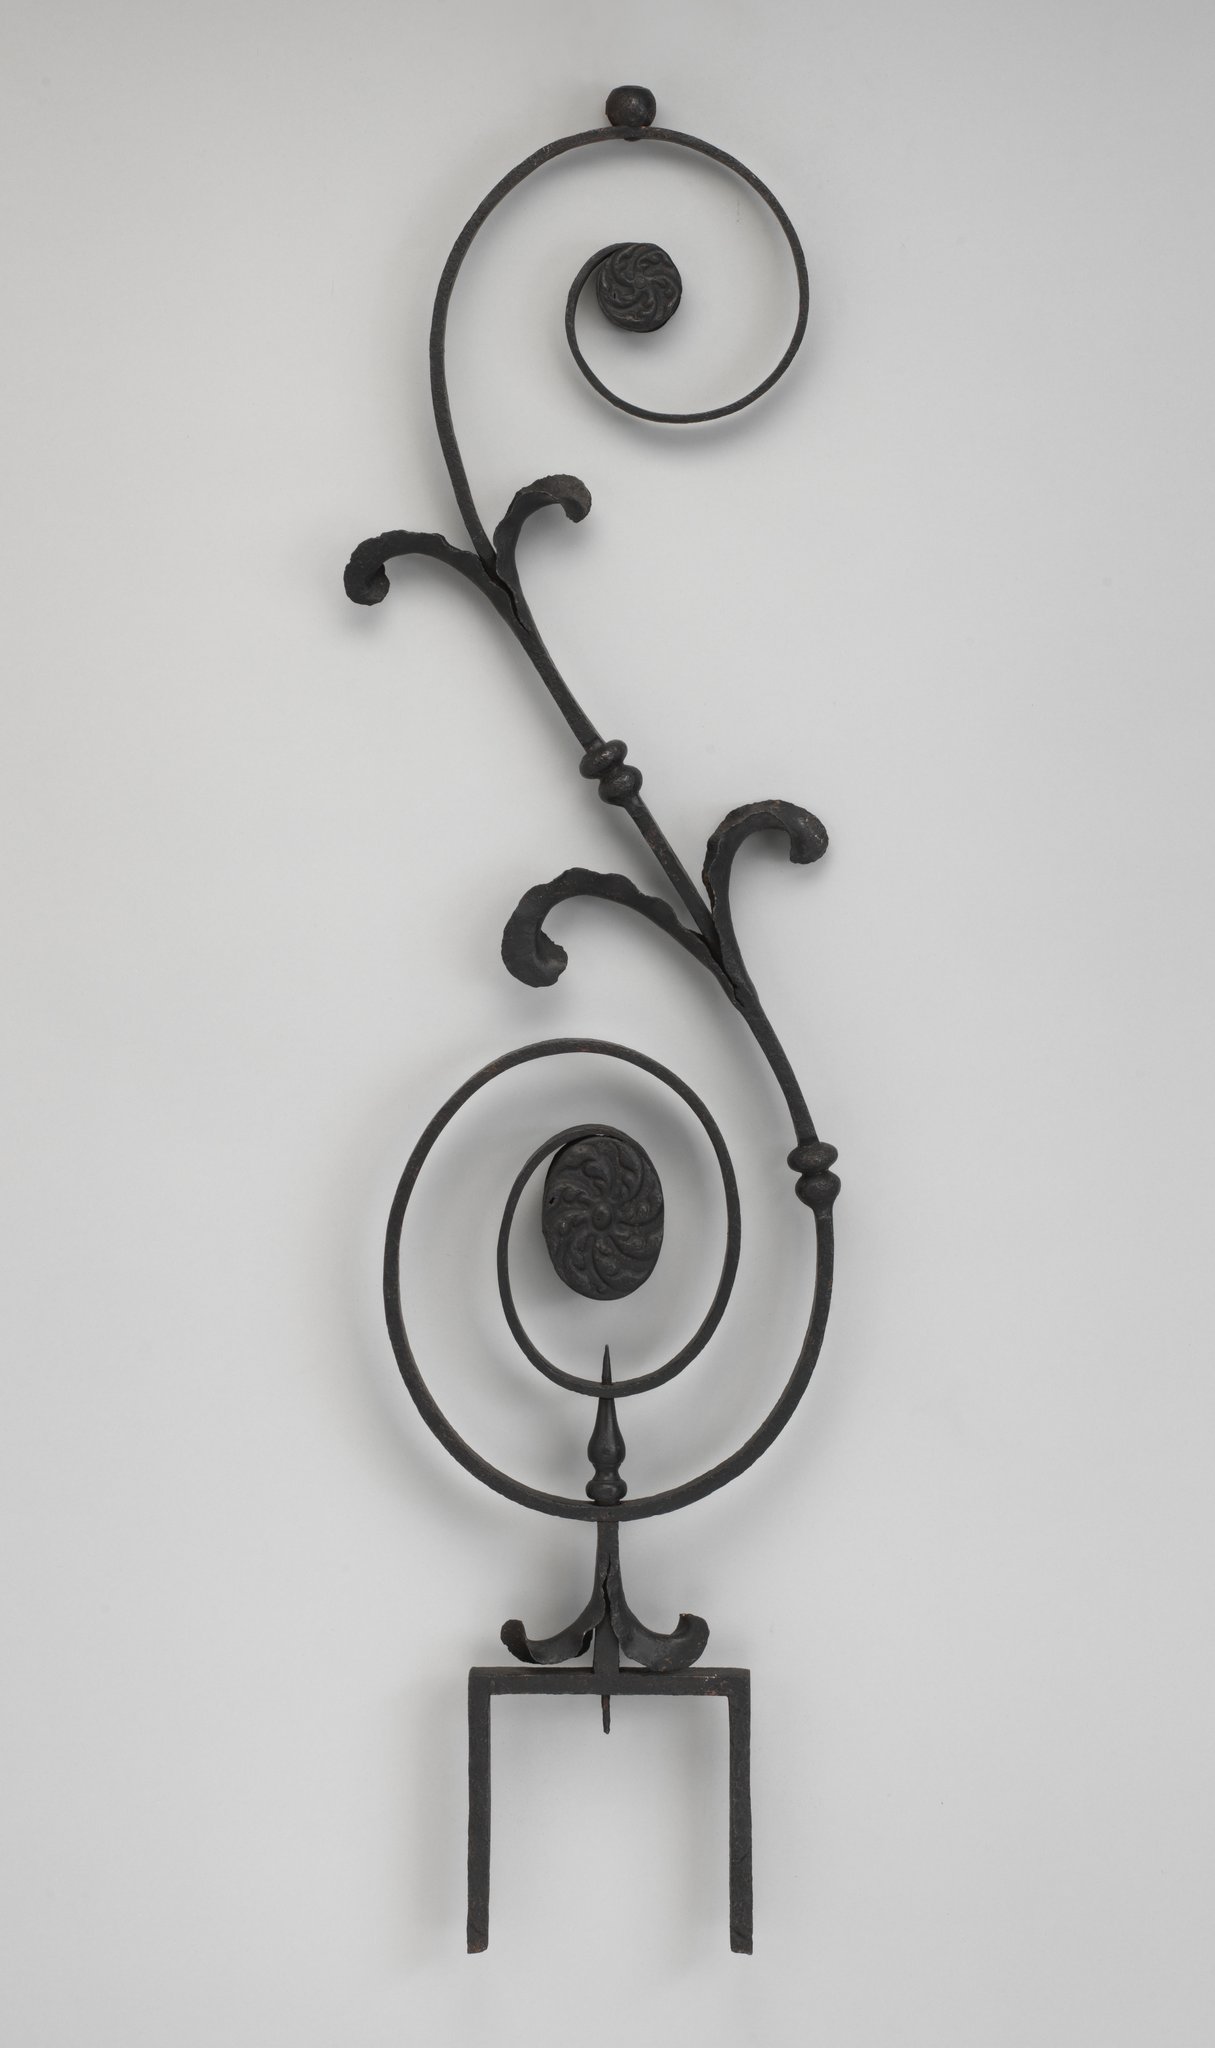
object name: baluster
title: Iron baluster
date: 1770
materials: iron